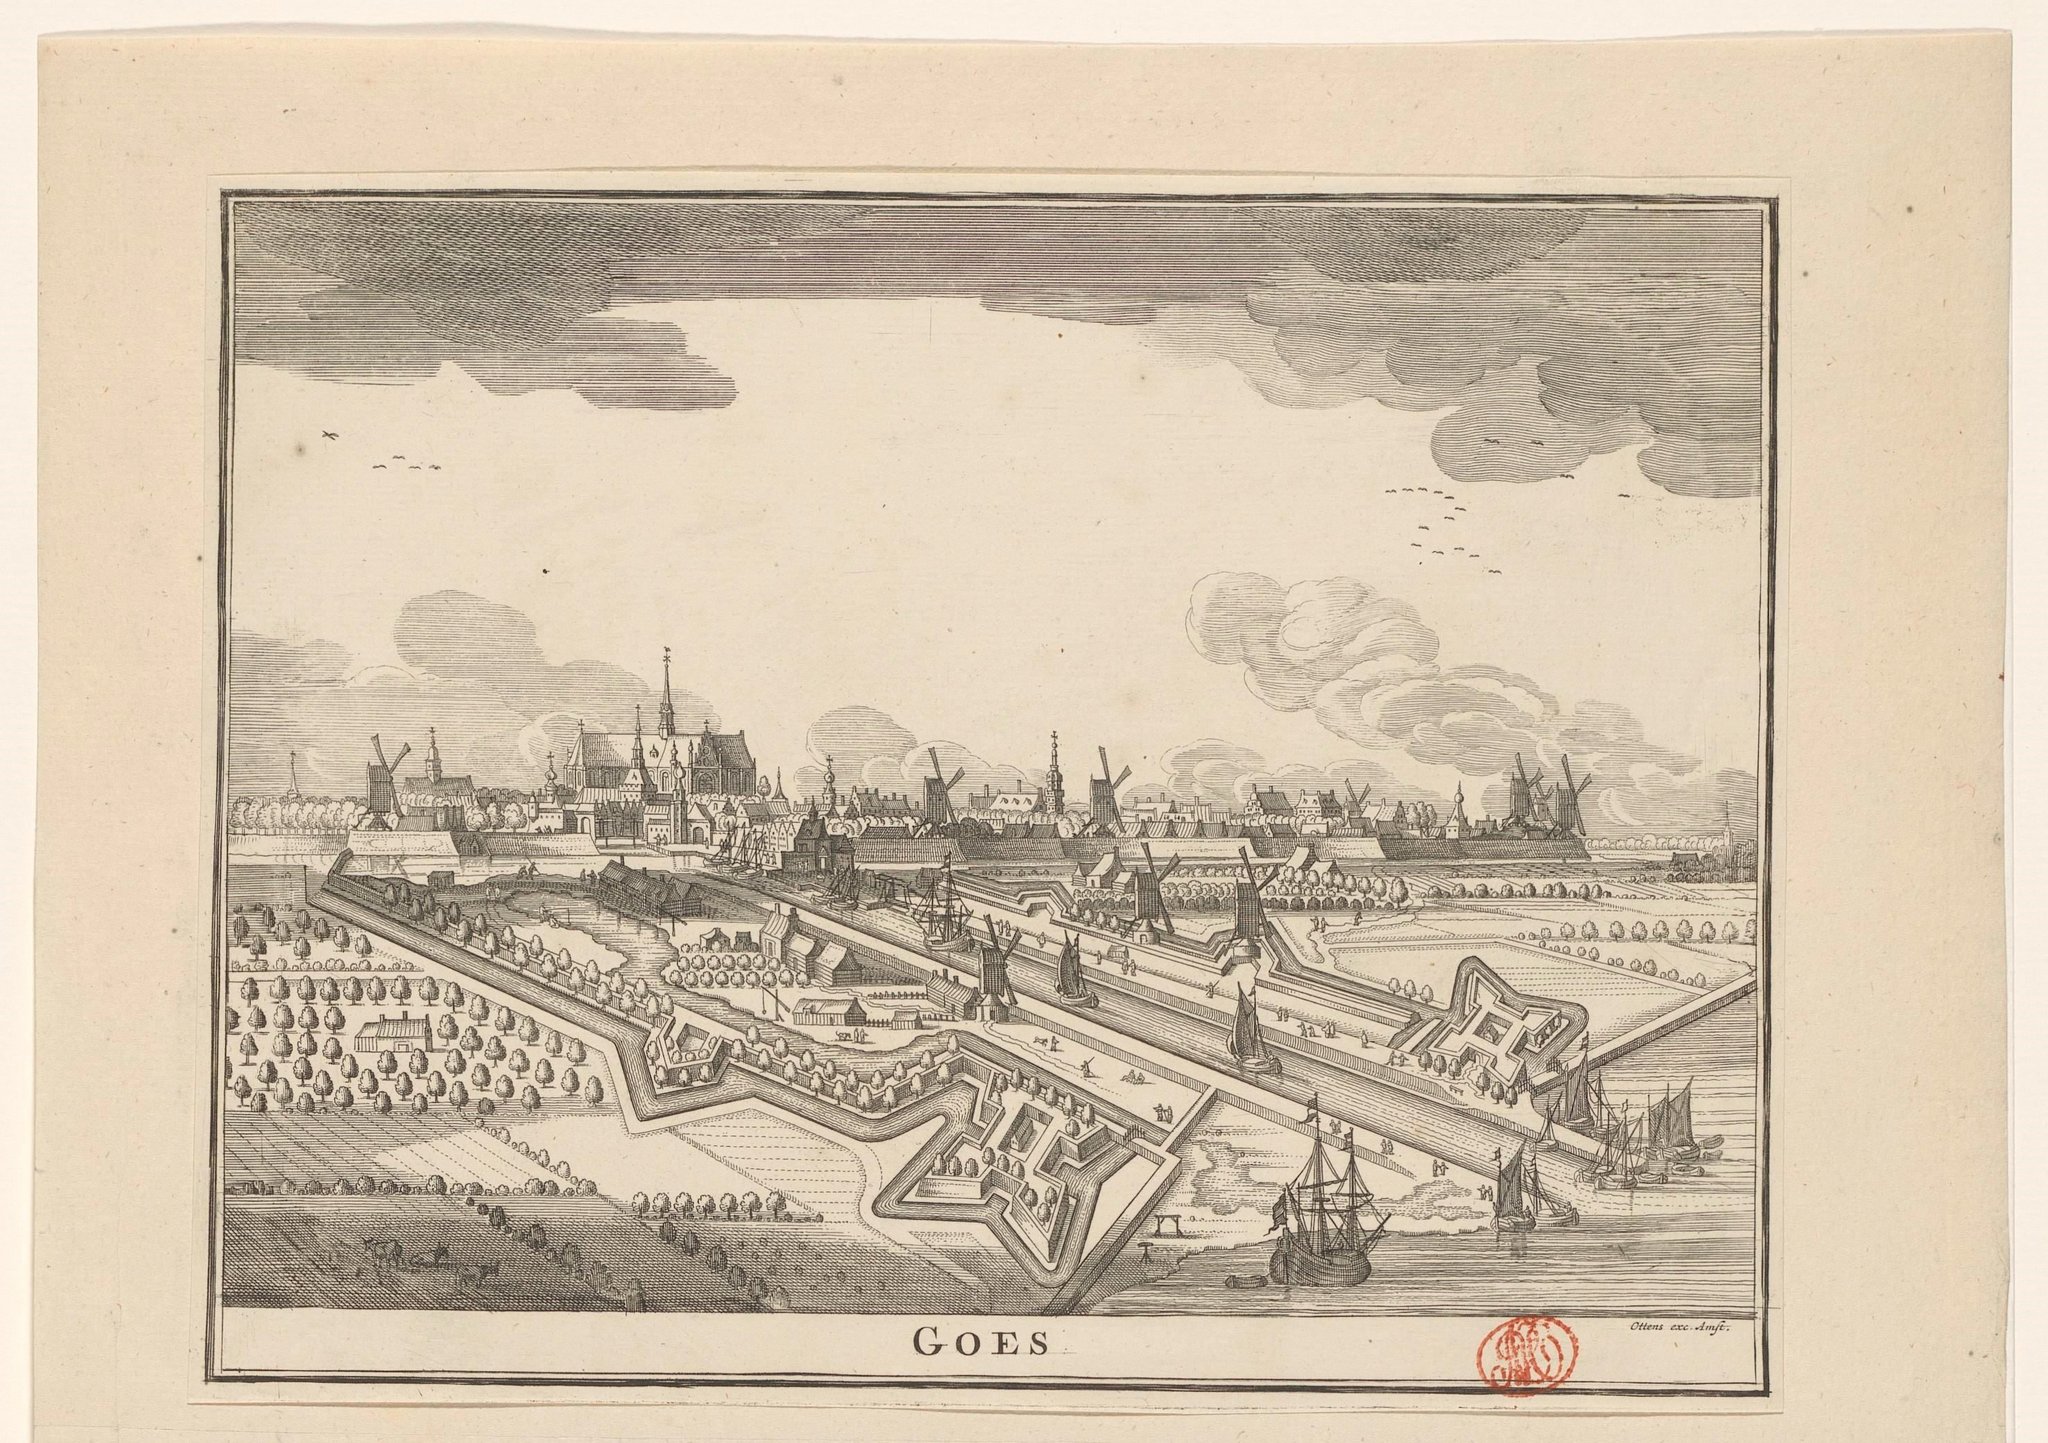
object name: print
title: Gezicht op Goes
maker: pieter hendricksz. schut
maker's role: print maker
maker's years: 1618-1660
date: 1657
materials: paper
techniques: engraving, etching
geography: amsterdam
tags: harbour, church (exterior), fortified city, windmill, prospect of city, town panorama, silhouette of city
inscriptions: collector's mark: Lugt 195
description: Prent ook gebruikt in: Speculum Zelandiae dat is een beschryvinge ofte afbeelding der steden, ambachts-heerlijckheden, dorpen castelen, ridderlijcke hofsteden, huysen en gebouwen gelegen inde eylanden en de graeflijckheyt van Zeelandt. Amsterdam: weduwe Ottens en Zoonen, s.a. [1719-1725]. Eerdere staat/staten van prent is/zijn gebruikt in eerdere uitgaven van 'Speculum Zelandiae' en in andere publicaties uitgegeven door Zacharias Roman en Nicolaes Visscher (I). De eerste publicatie waarin de eerste staat van de huidige prent voorkomt dateert uit 1657. Verwarring rondom de datering kan ontstaan door het feit de prenten uit 'Speculum Zelandiae' ook voorkomen in eerder uitgegeven publicaties, waar ze later in zijn ingebonden. Zo komen prenten uitgegeven door Roman/Visscher voor in sommige exemplaren van: Boxhorn, Marcus Zuerius van. Chroniick van Zeelandt (…). 2 delen. Middelburg: Zacharias Roman, 1644. De door weduwe (Joachim) Ottens en Zoonen uitgegeven prenten zijn later ingebonden in sommige exemplaren van: Smallegange, Mattheus. Nieuwe Cronyk van Zeeland (…). Middelburg en Amsterdam: Johannes Meertens en Abraham van Someren, 1696.